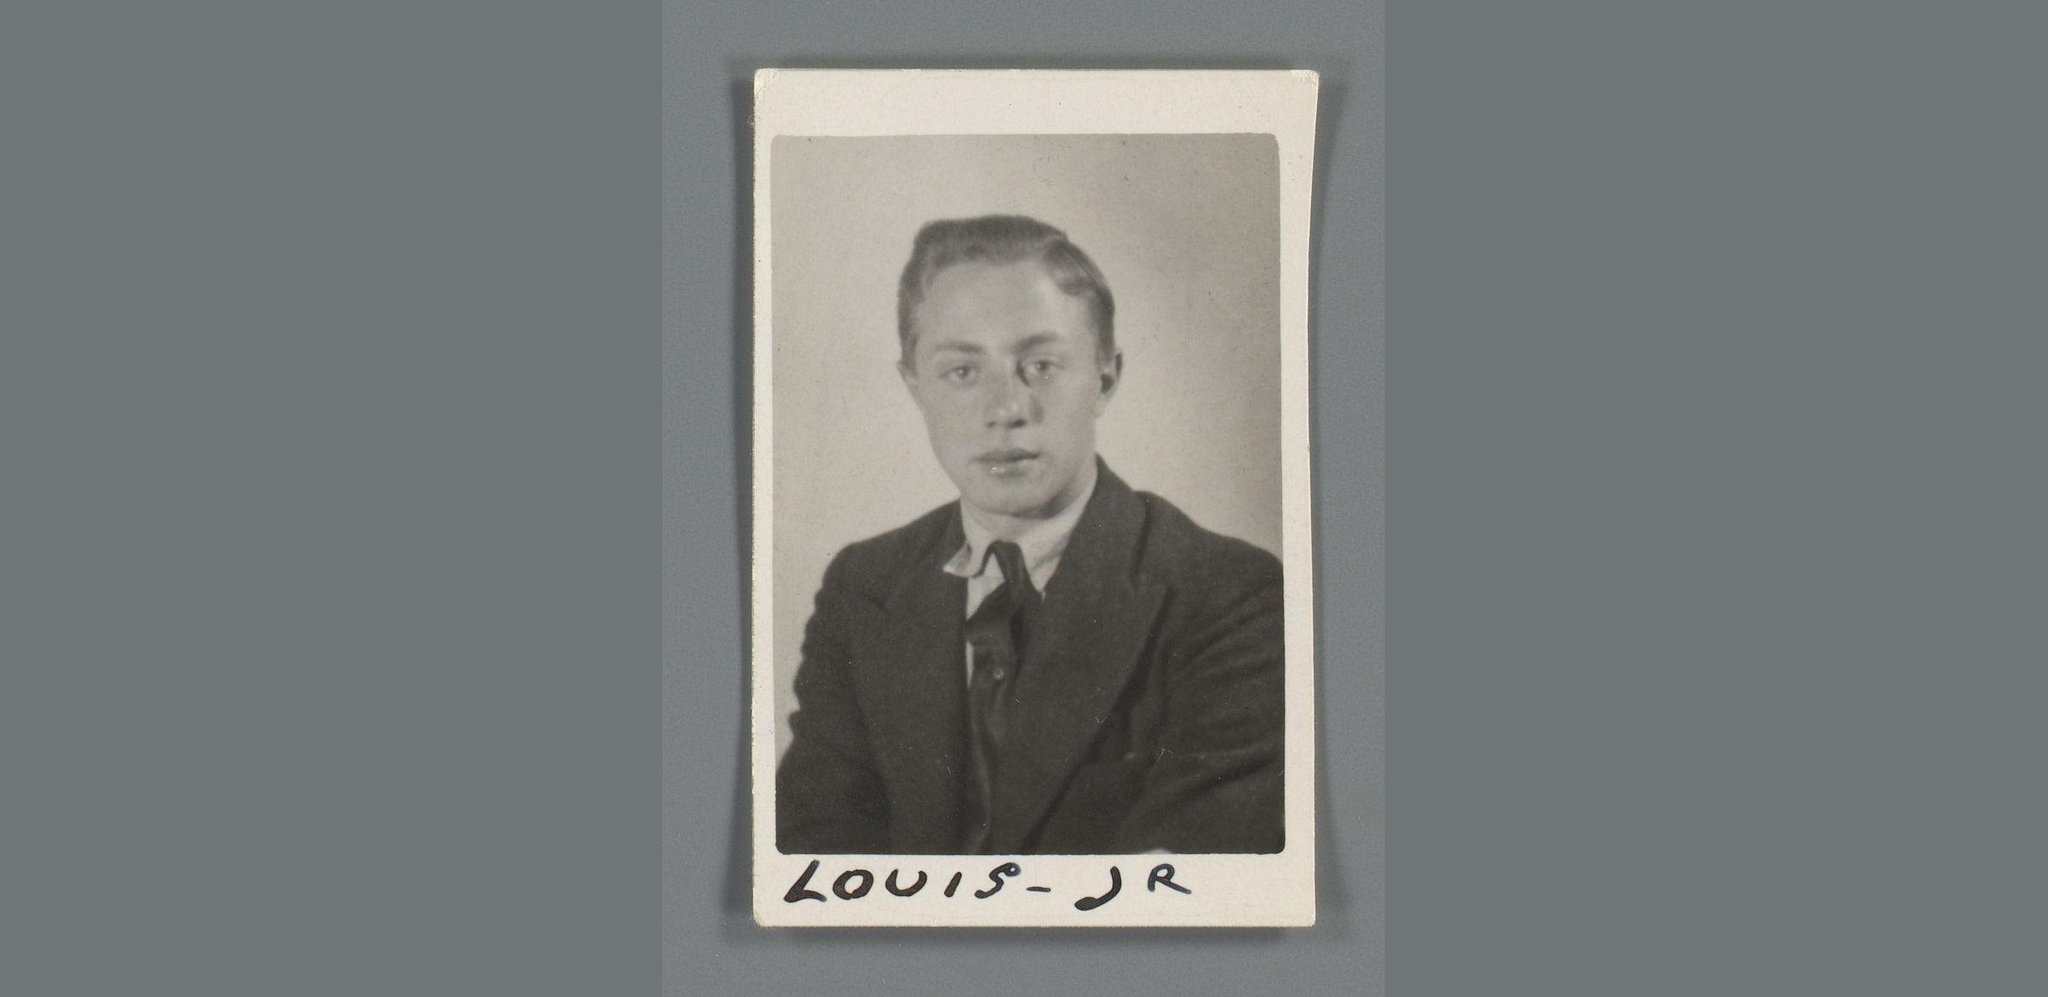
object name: passport photograph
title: Portret van een onbekende jongeman, aangeduid als Louis jr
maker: michiel hijmans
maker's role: fotograaf, handelaar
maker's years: 1876-1942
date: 1938-1942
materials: paper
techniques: gelatin silver print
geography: schiedam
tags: historical persons not known by name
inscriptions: stamp: ‘Hymans' fotohandel/ Broersvest 48, Tel. 67605/ Hoogstraat 15, Tel. 67582’